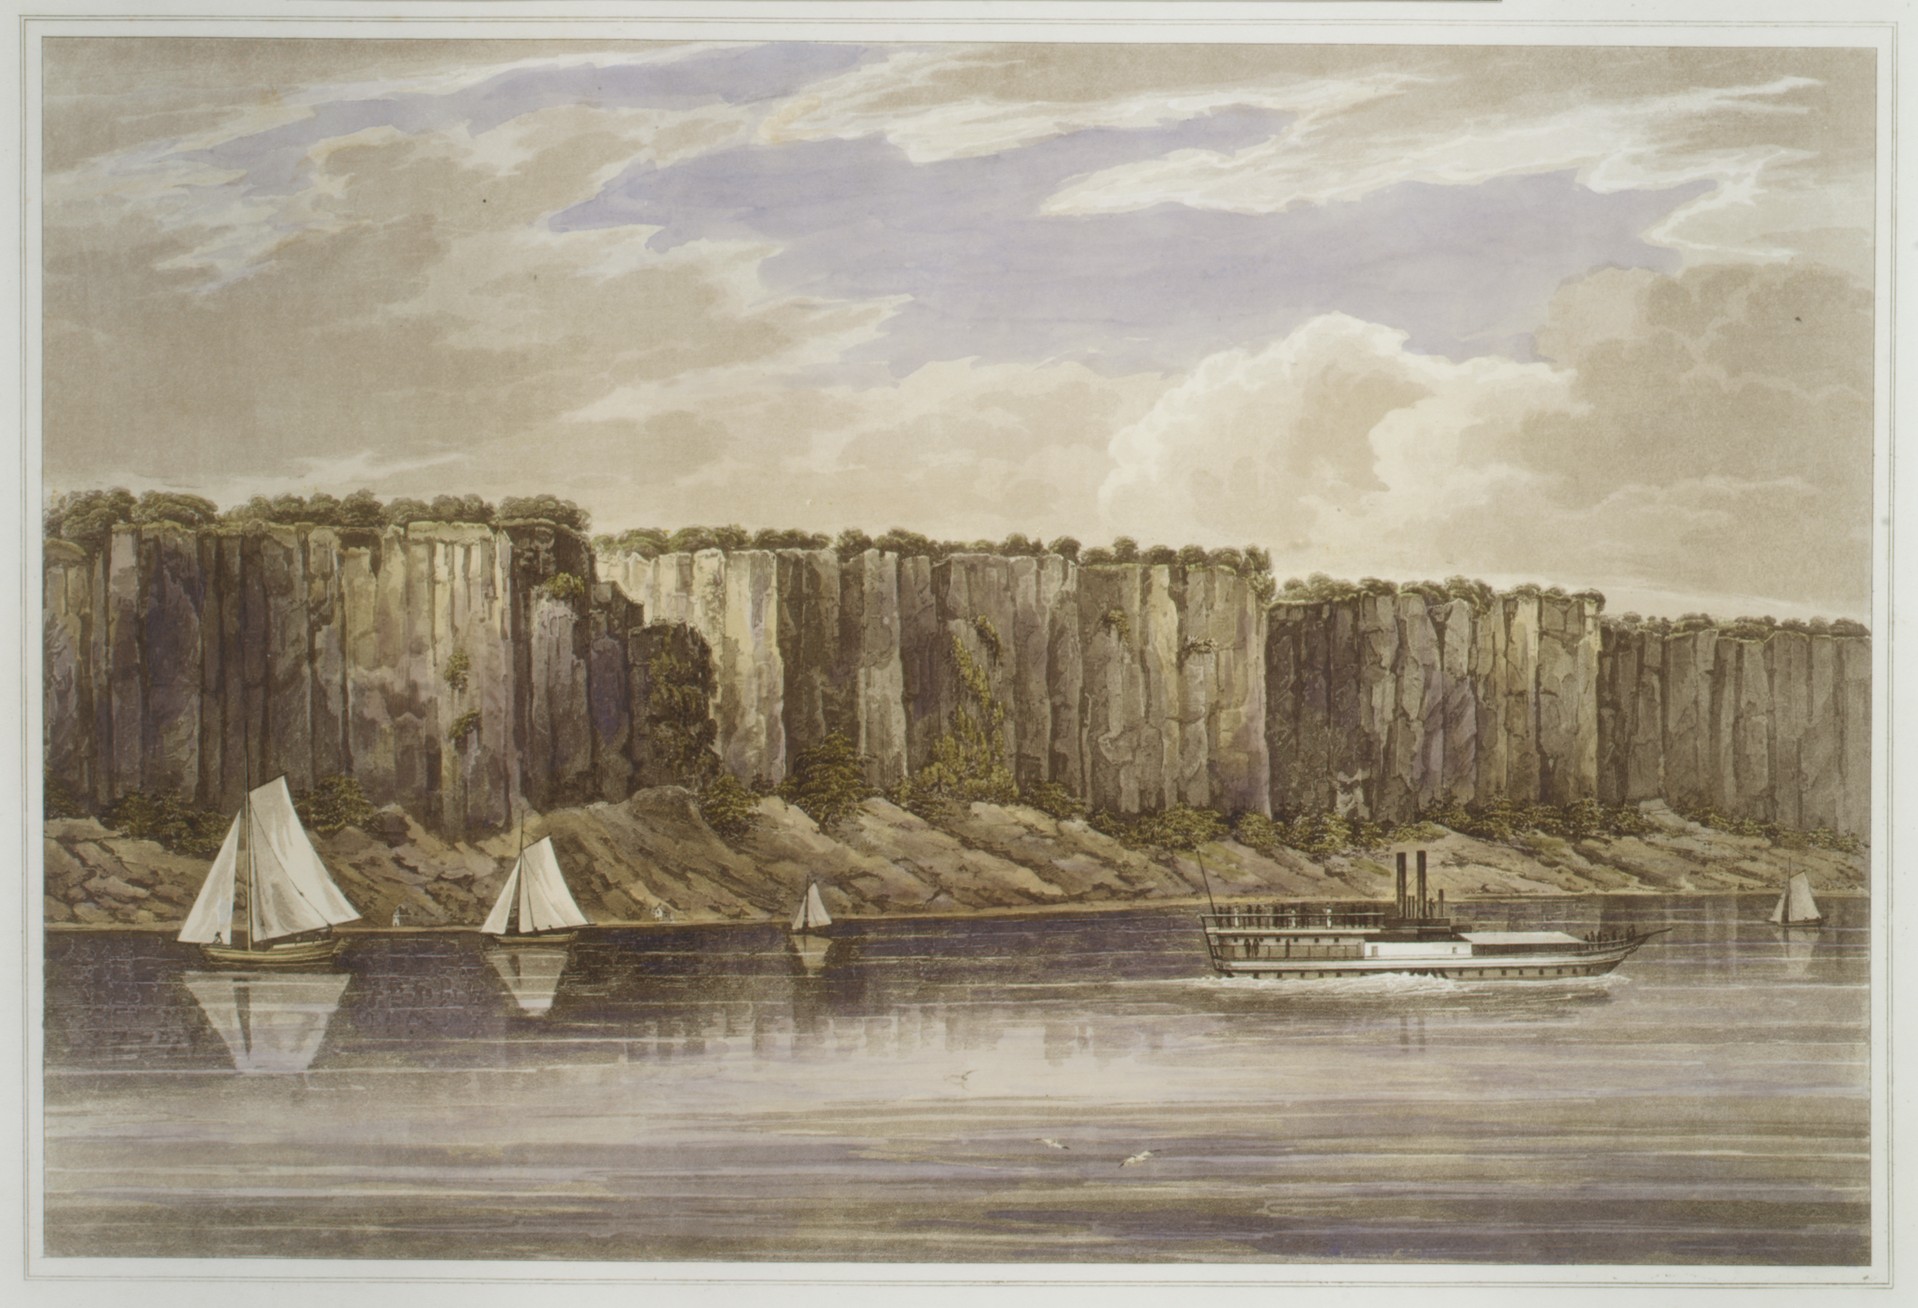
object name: print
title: Palisades (No. 19 of The Hudson River Portfolio)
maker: john hill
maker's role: etcher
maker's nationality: american, born england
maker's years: 1770-1850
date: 1823-1824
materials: watercolor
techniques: aquatint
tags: rivers,boats,ships